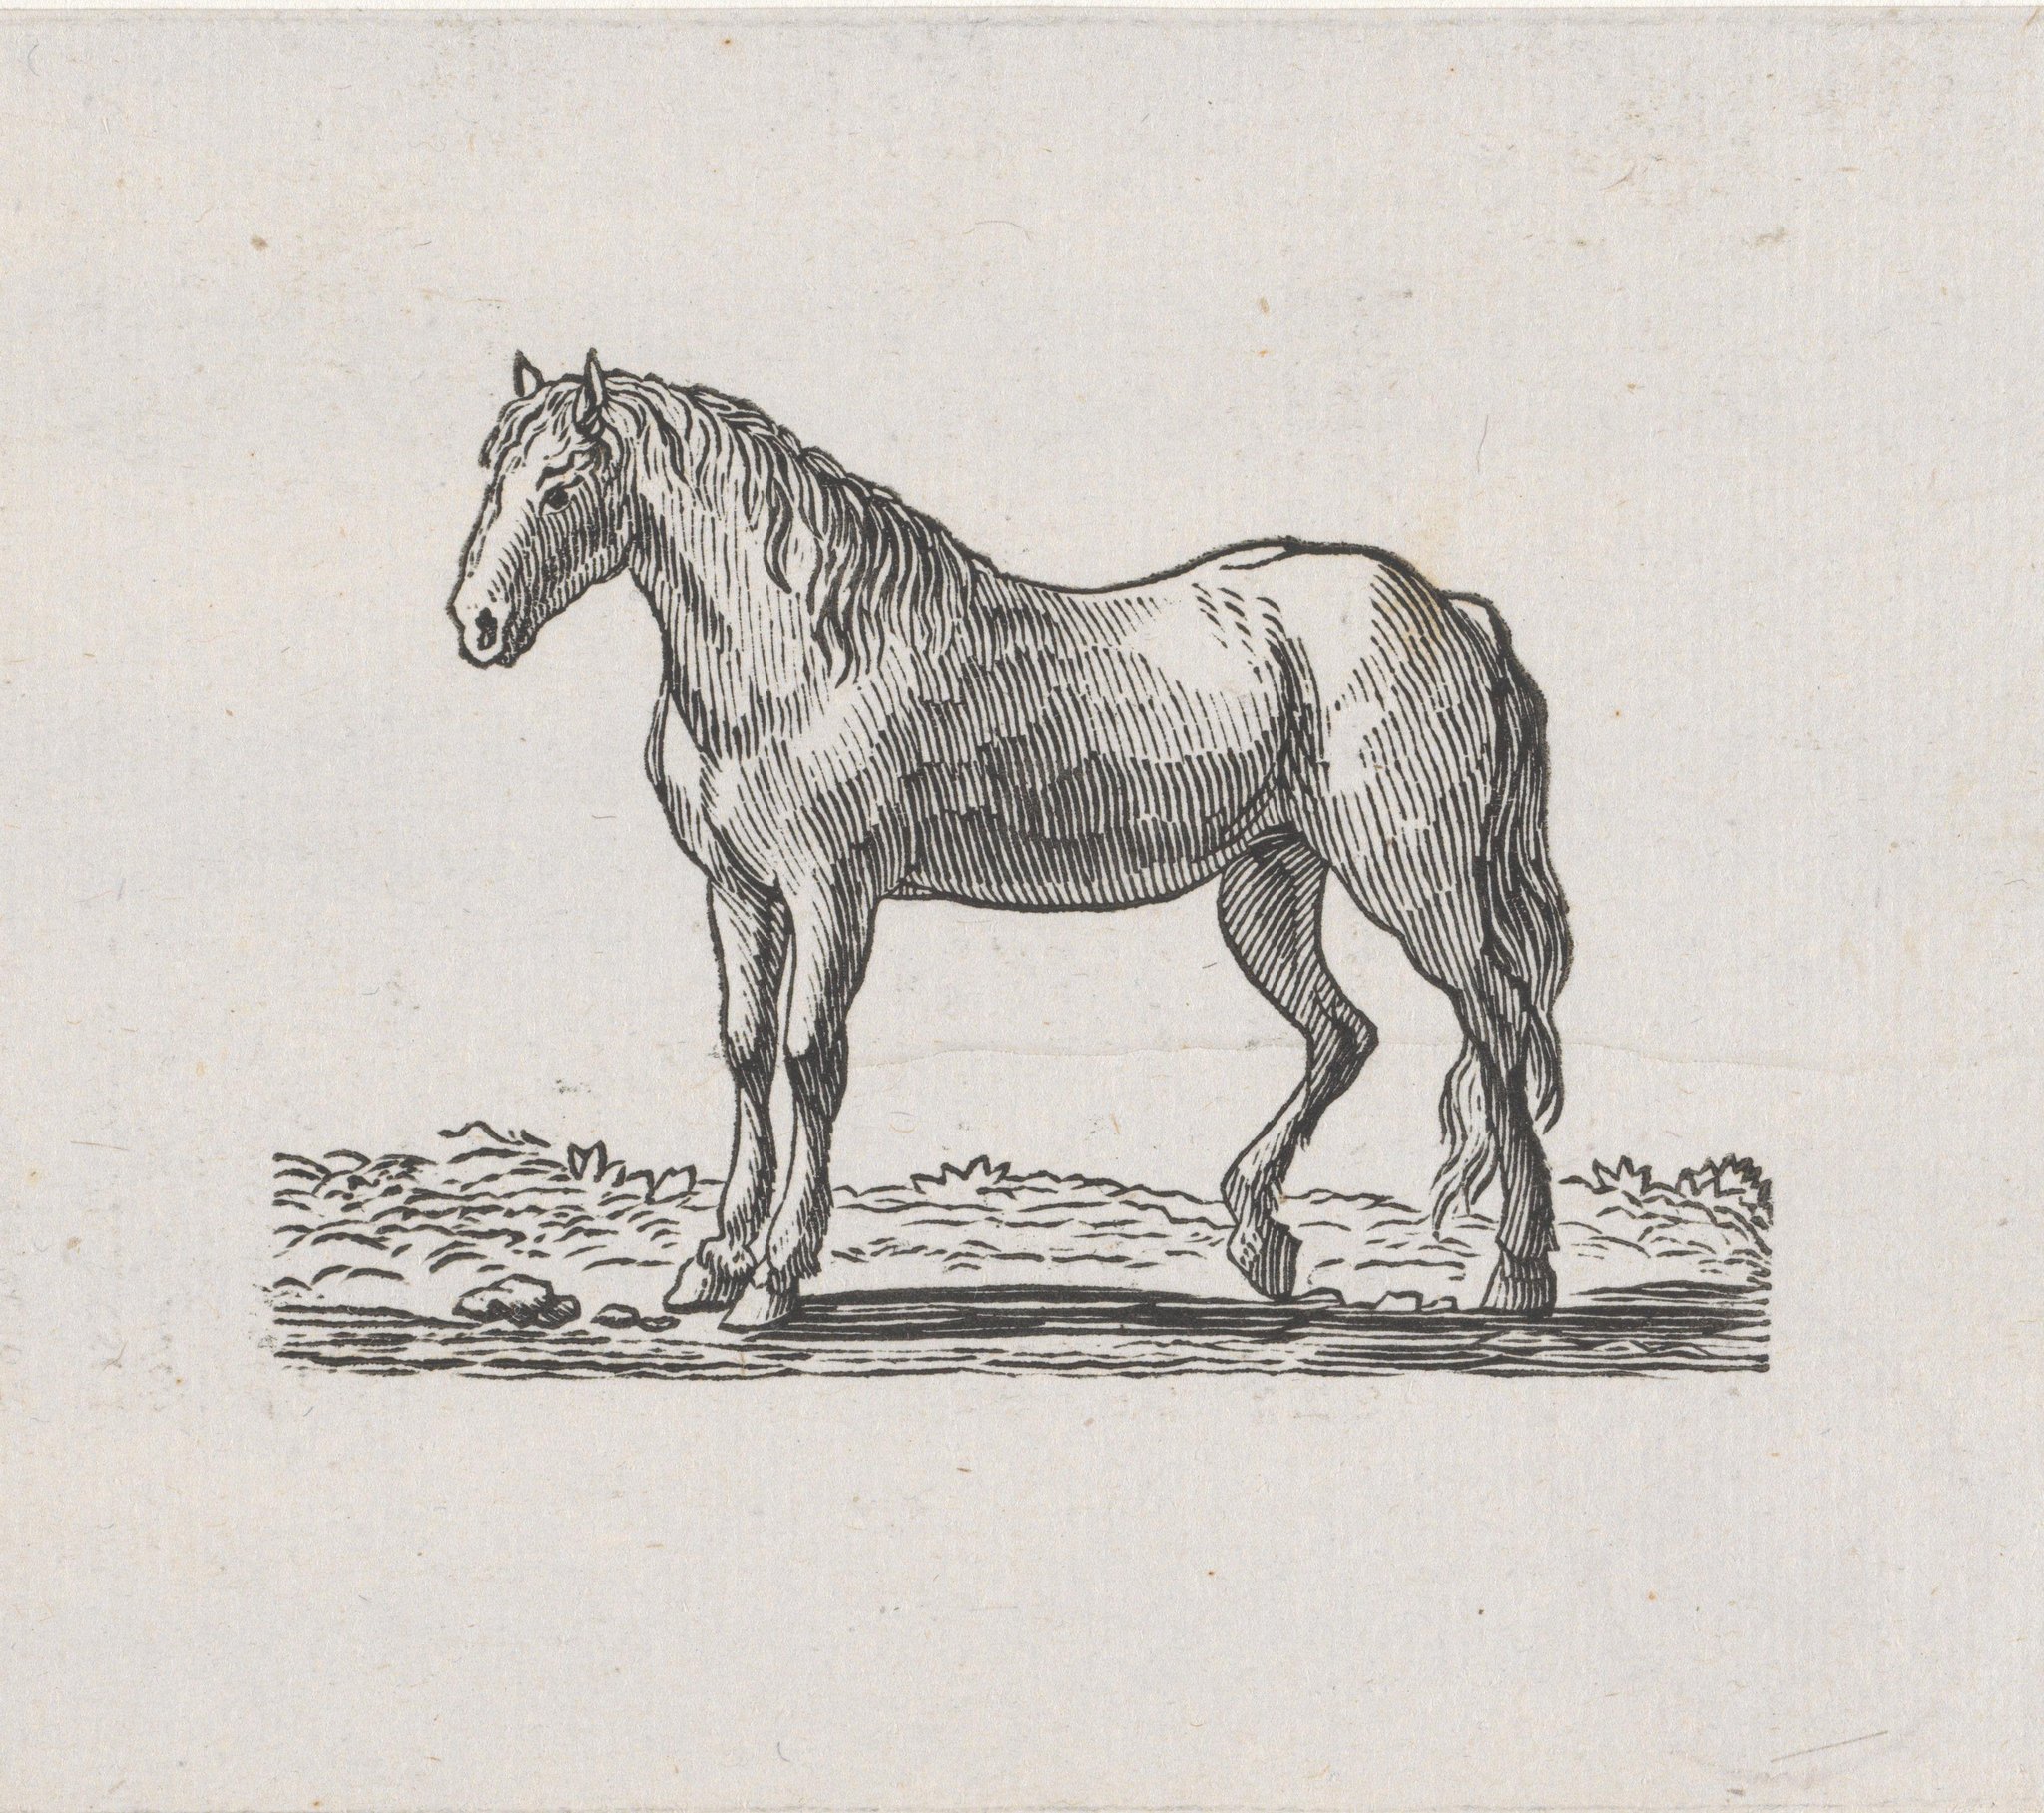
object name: print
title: Paard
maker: hendrik numan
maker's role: draughtsman, print maker, publisher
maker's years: 1736-1788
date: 1746-1788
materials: paper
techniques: woodcut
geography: haarlem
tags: horse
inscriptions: collector's mark: Lugt 240